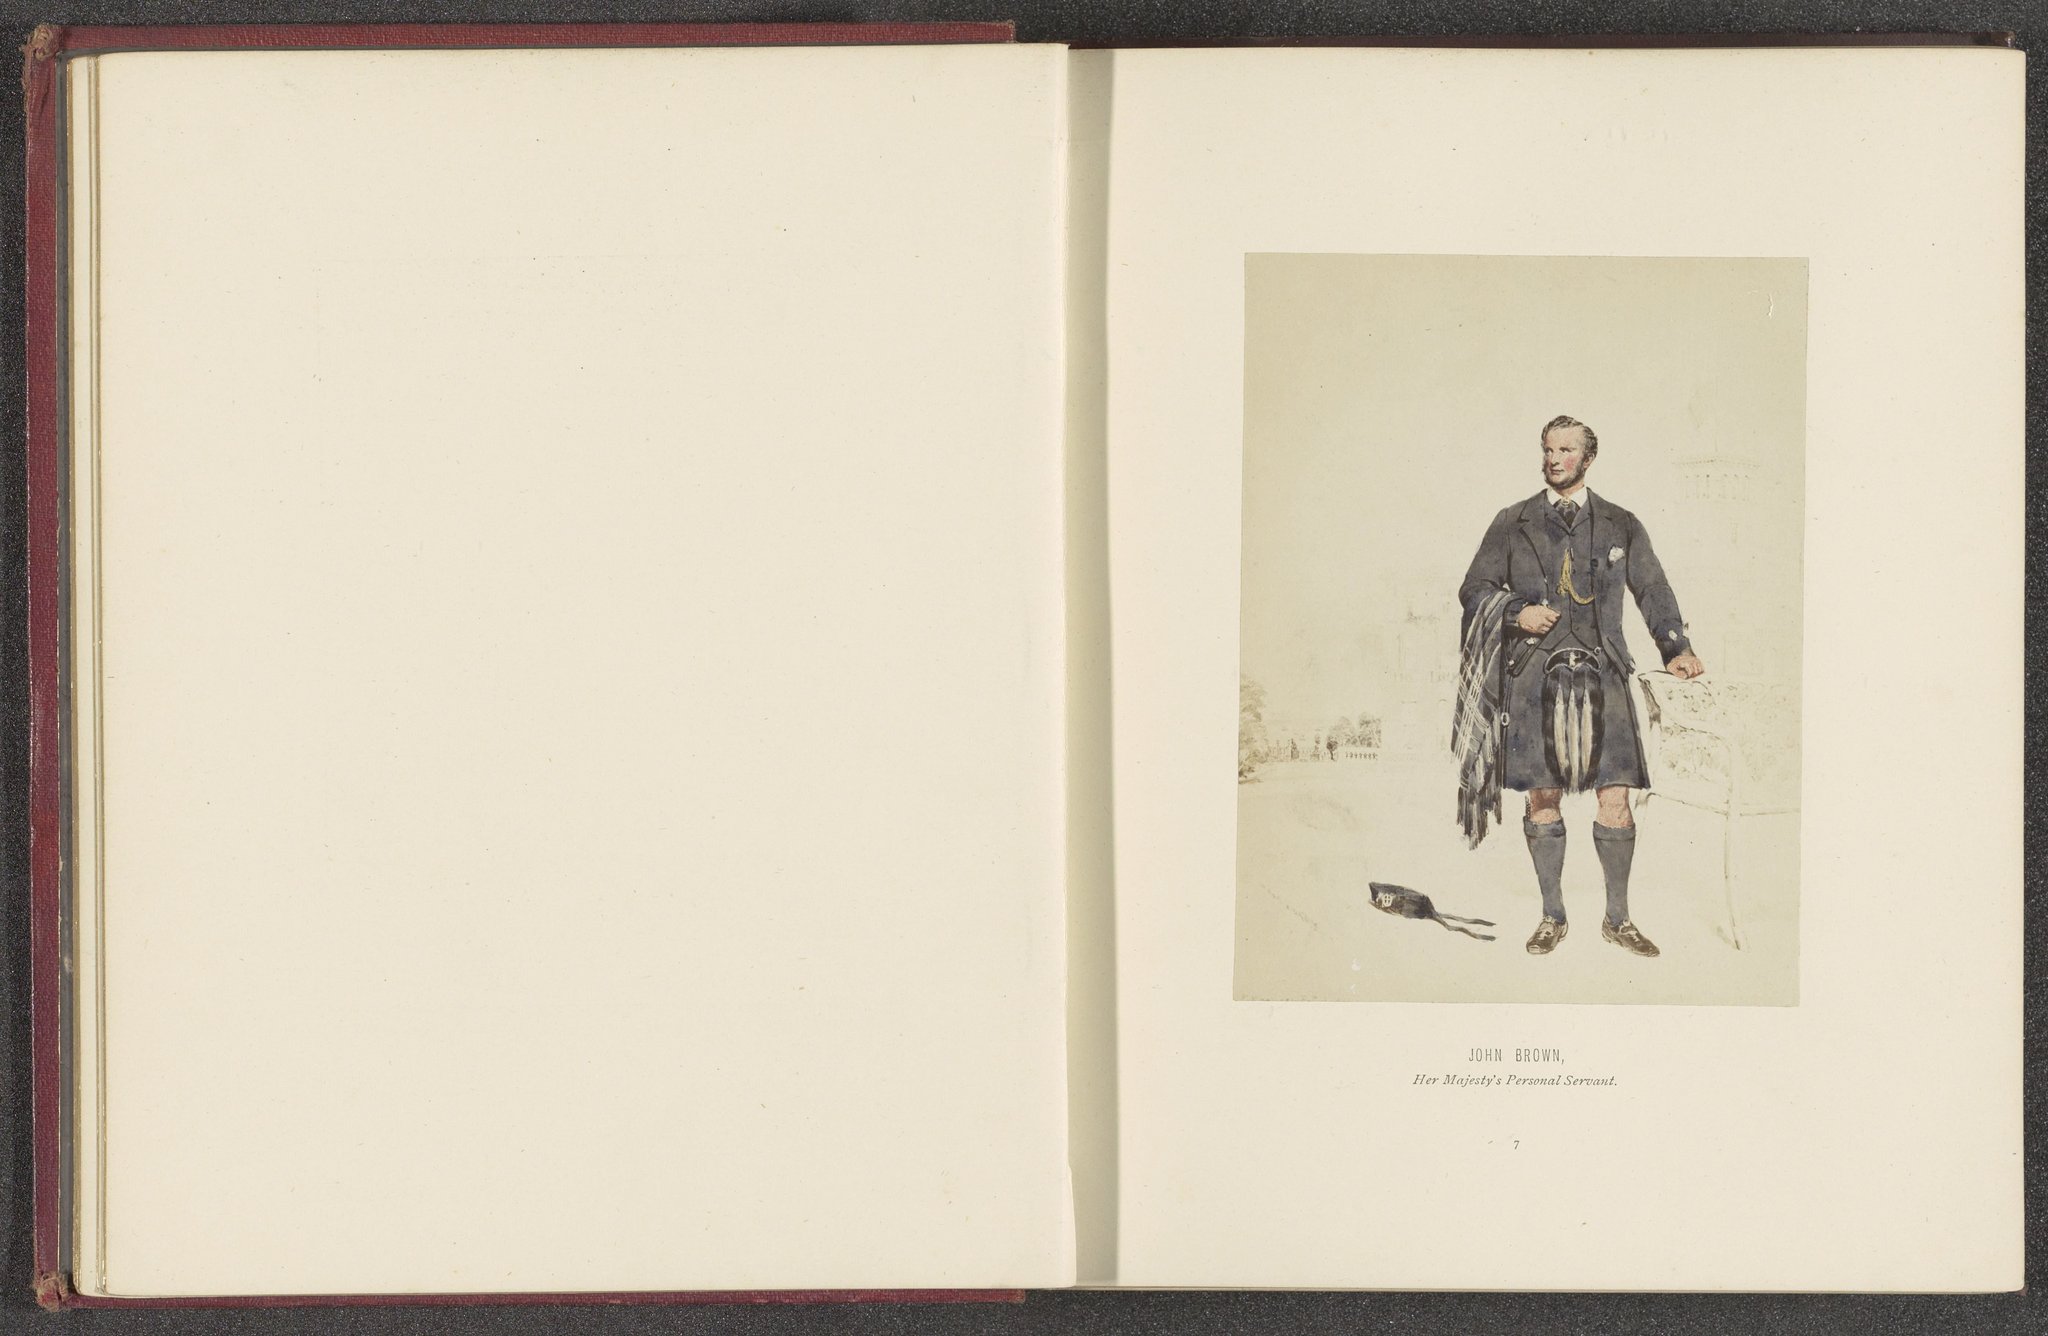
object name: photograph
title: Fotoreproductie van een tekening van een portret van John Brown, de persoonlijke bediende van Victoria van het Verenigd Koninkrijk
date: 1860-1870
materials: photographic support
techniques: albumen print, hand coloring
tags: adult man, servant